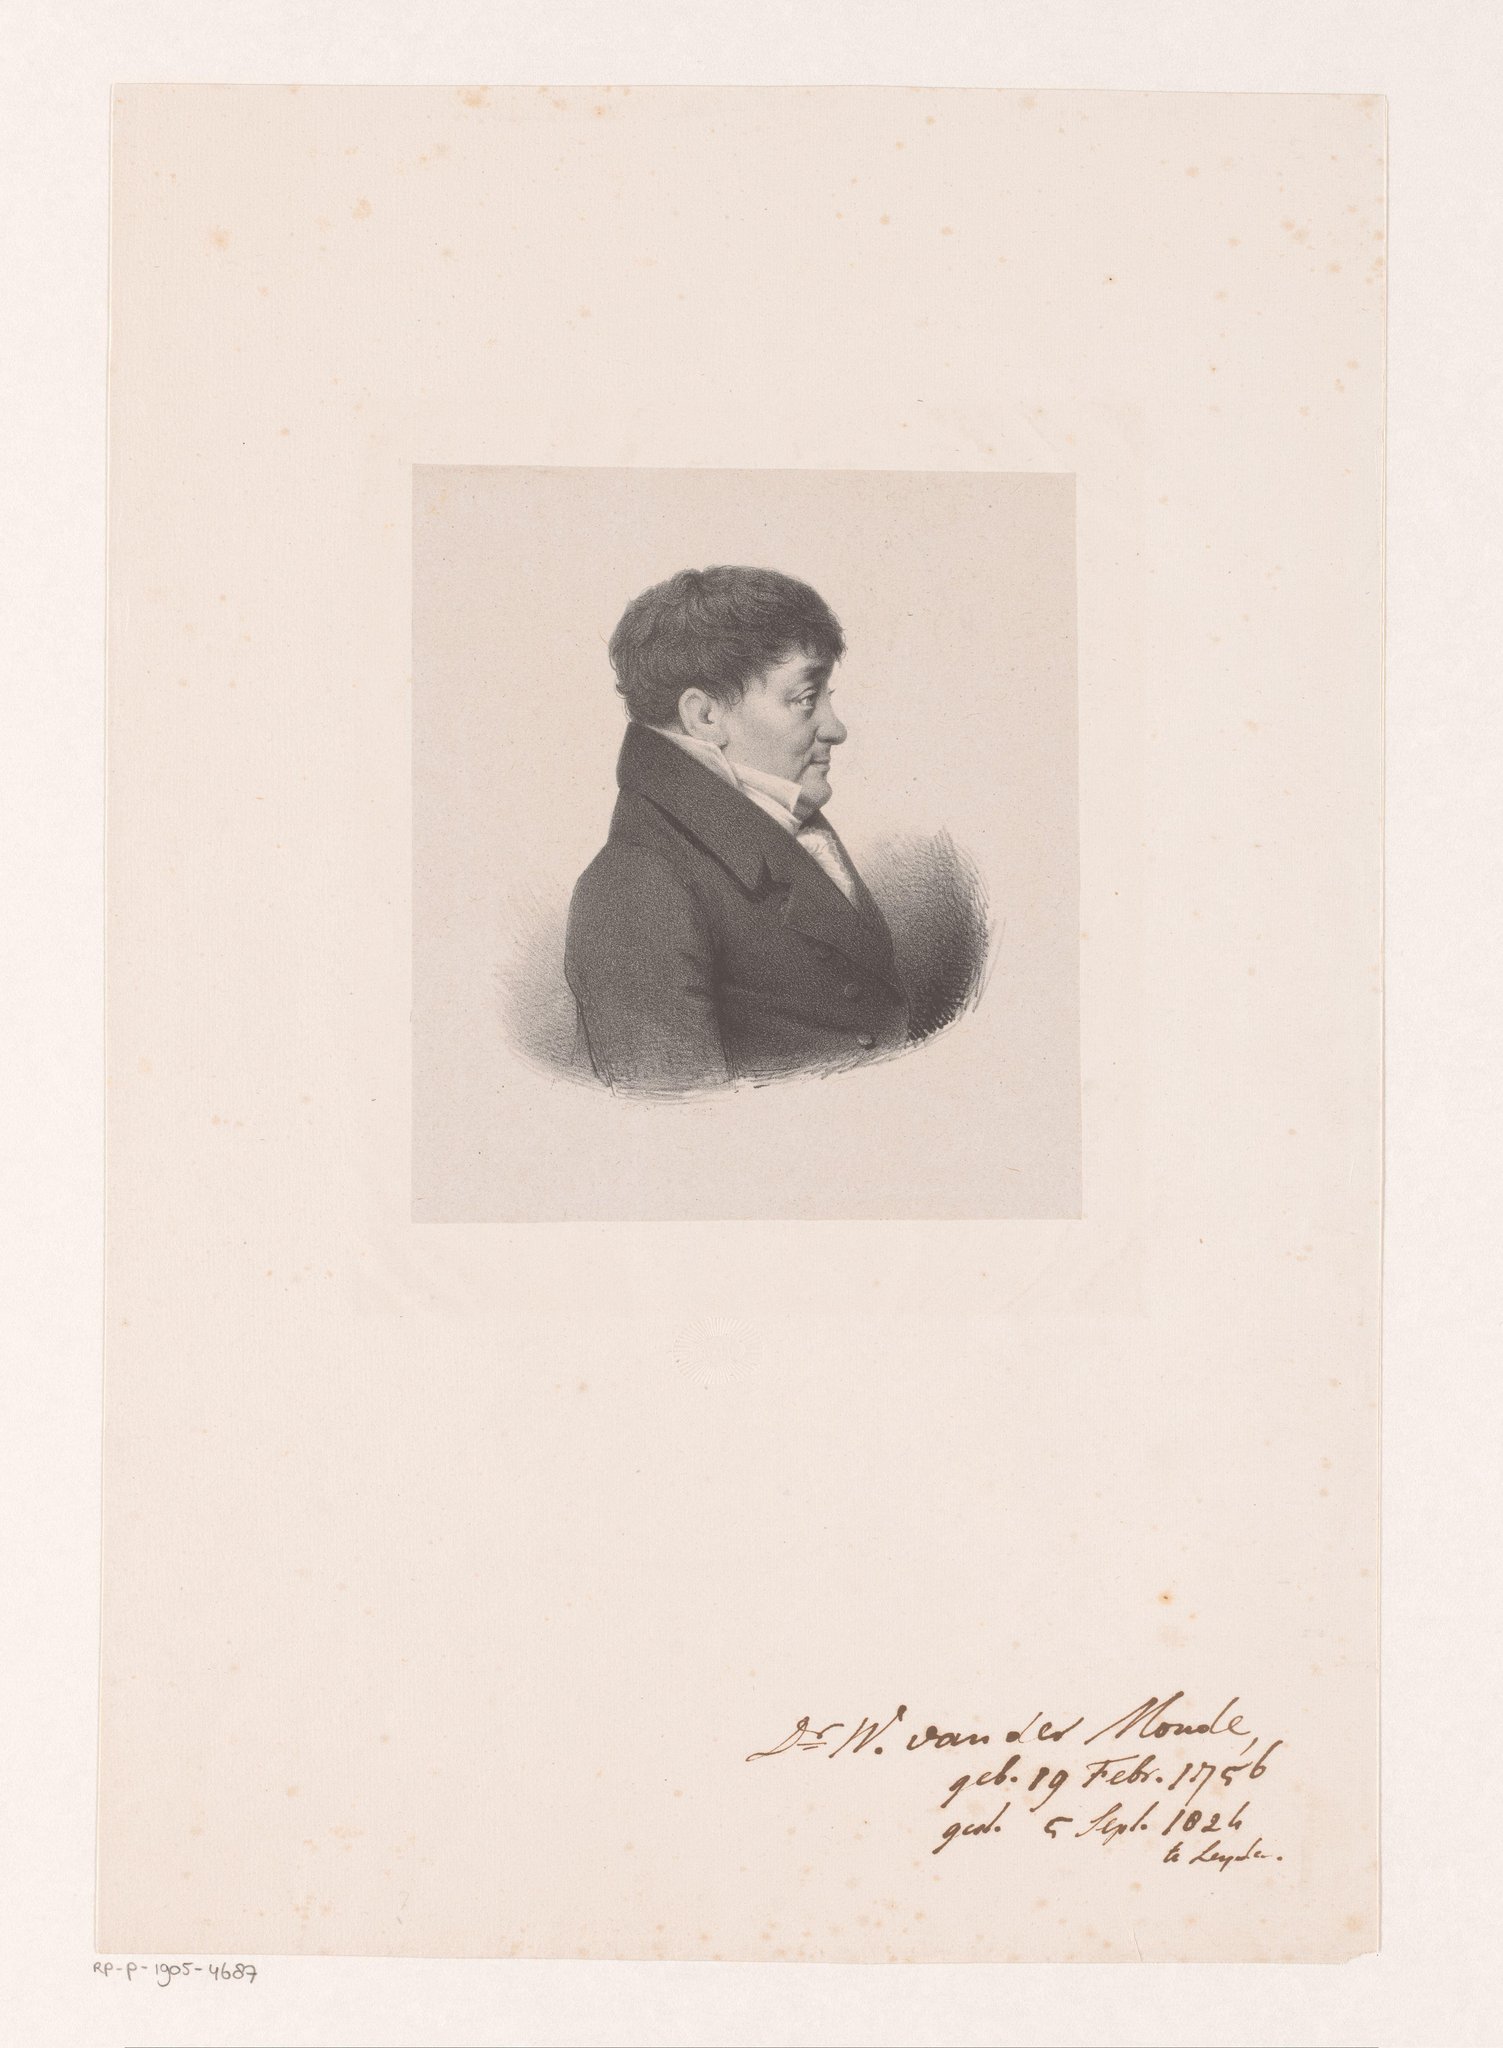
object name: print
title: Portret van W. van der Monde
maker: Anonymous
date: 1830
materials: paper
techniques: lithograph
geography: den bosch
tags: historical persons (+ profile portrait)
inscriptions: collector's mark: Lugt 2228